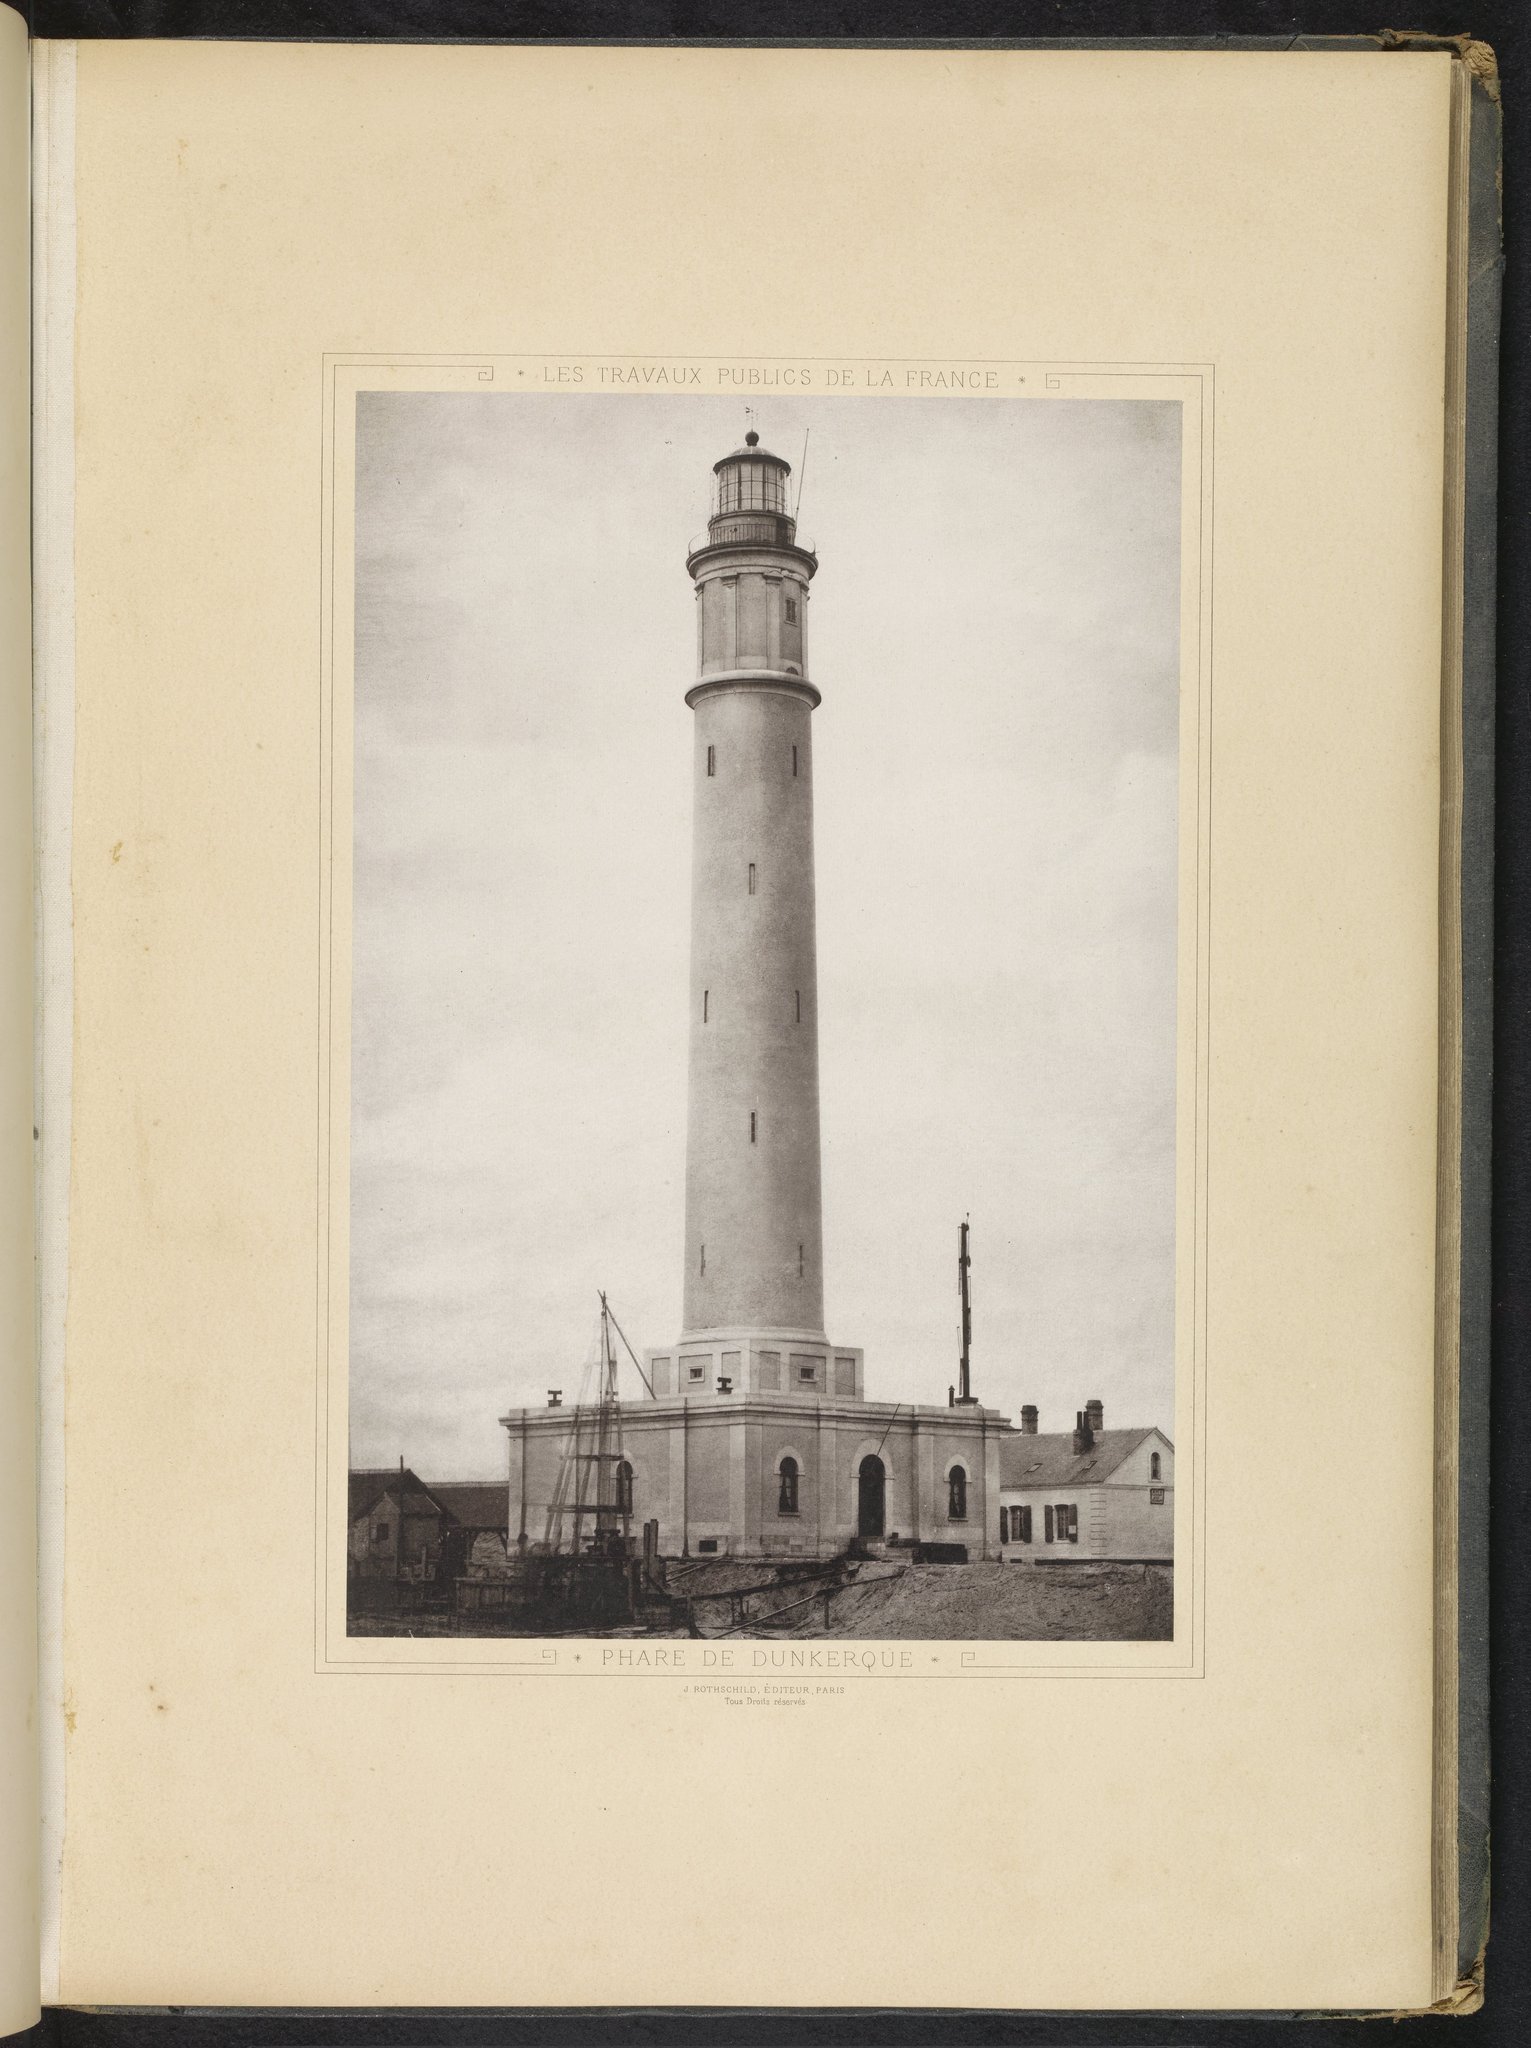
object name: photomechanical print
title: Vuurtoren van Duinkerke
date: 1873-1883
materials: paper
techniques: photograph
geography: france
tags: lighthouse, lightship